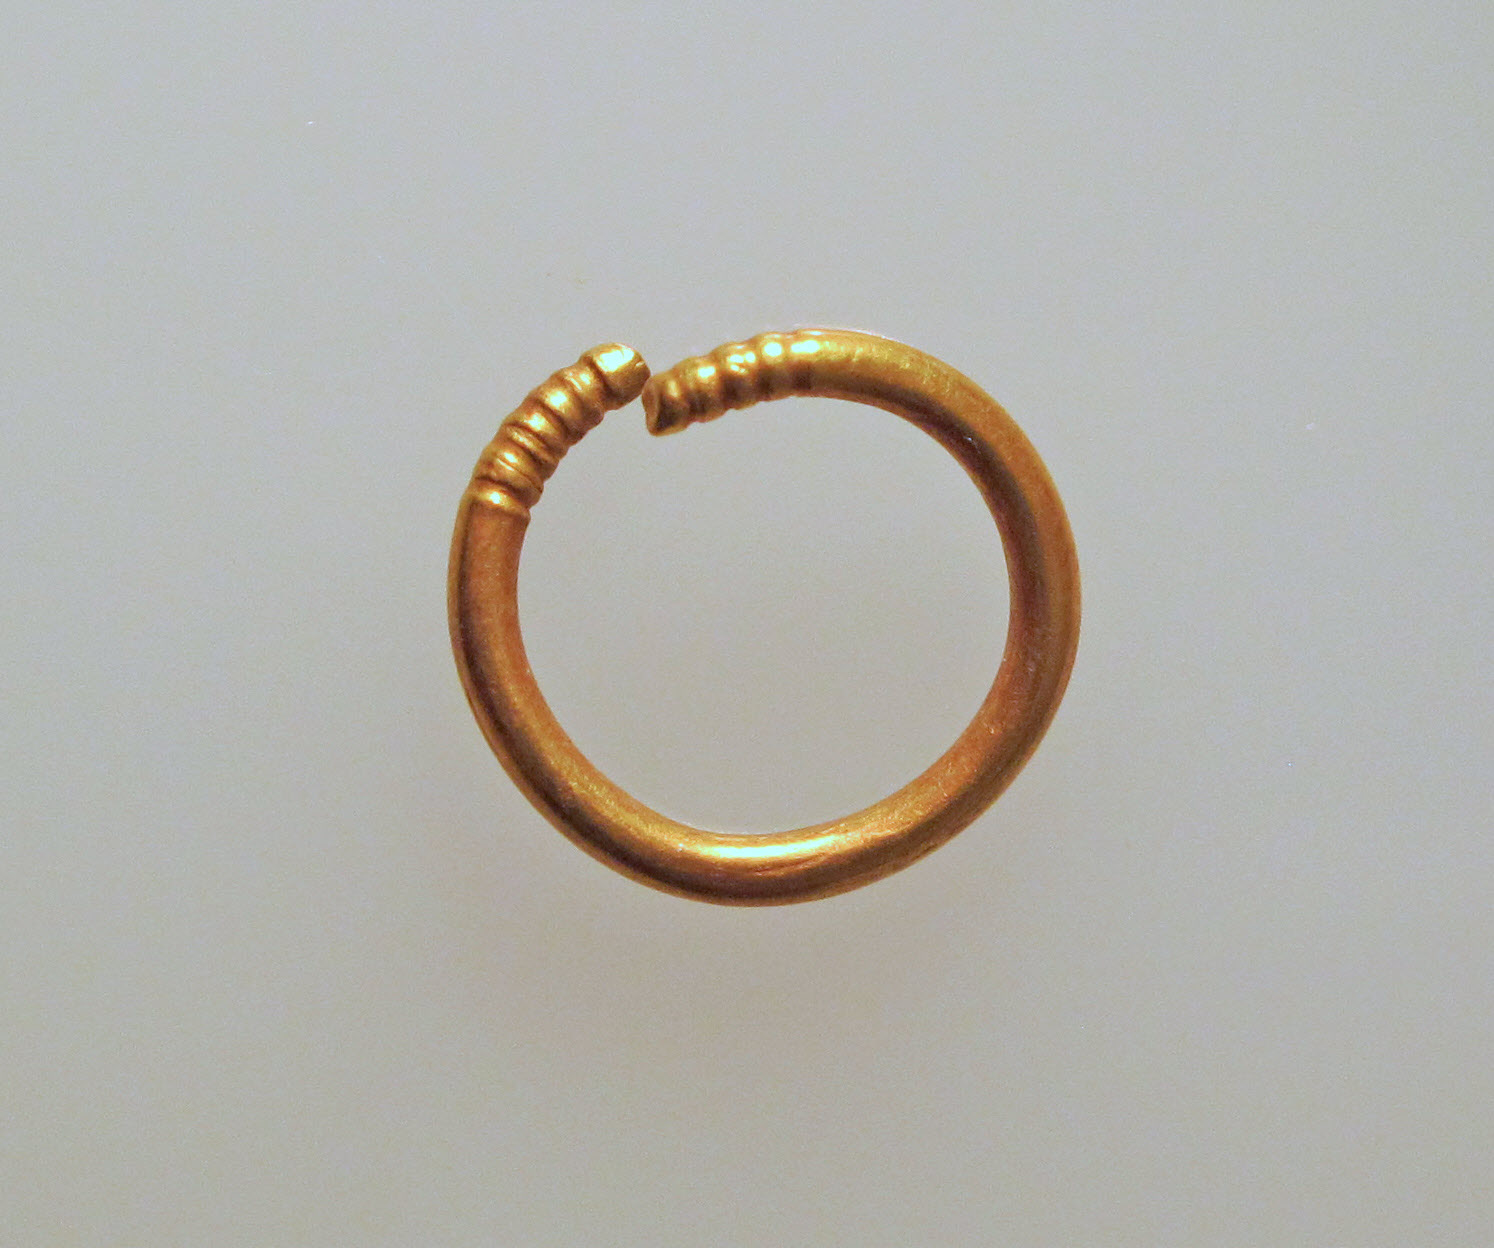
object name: spiral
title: Spirals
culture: cypriot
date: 3900 BCE-100 CE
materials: gold